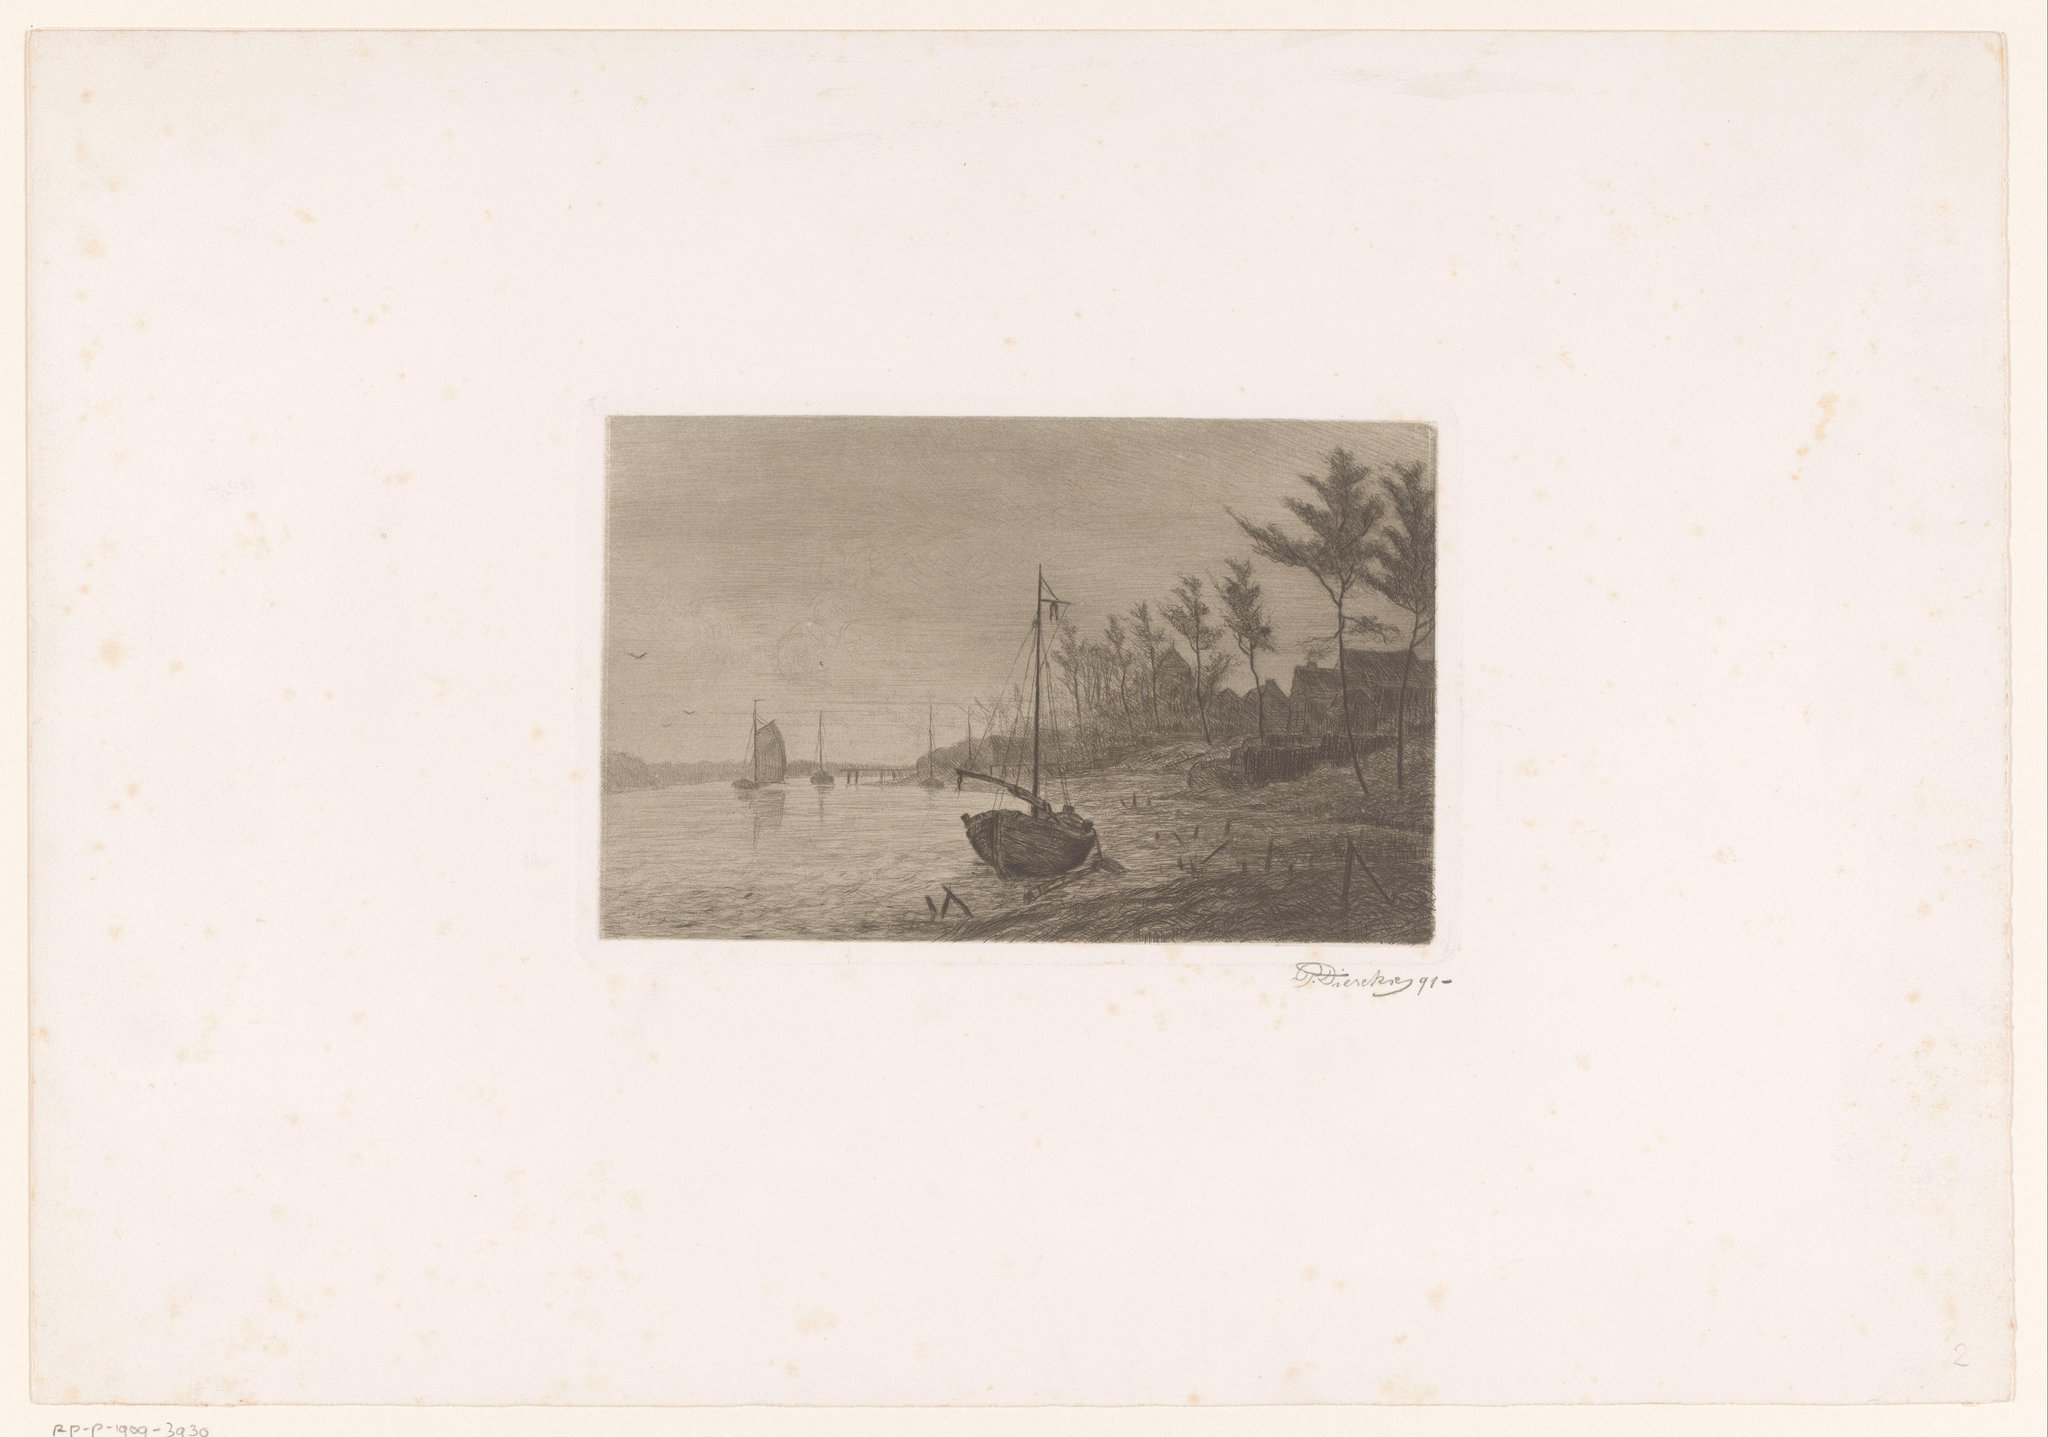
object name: print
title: Dorp aan een rivier met een boot langs de oever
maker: pierre jacques dierckx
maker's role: painter, print maker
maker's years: 1855-1947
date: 1891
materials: paper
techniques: drypoint, etching, intaglio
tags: prospect of village, silhouette of village, river, ships, boats on land, beached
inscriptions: collector's mark: Lugt 2228